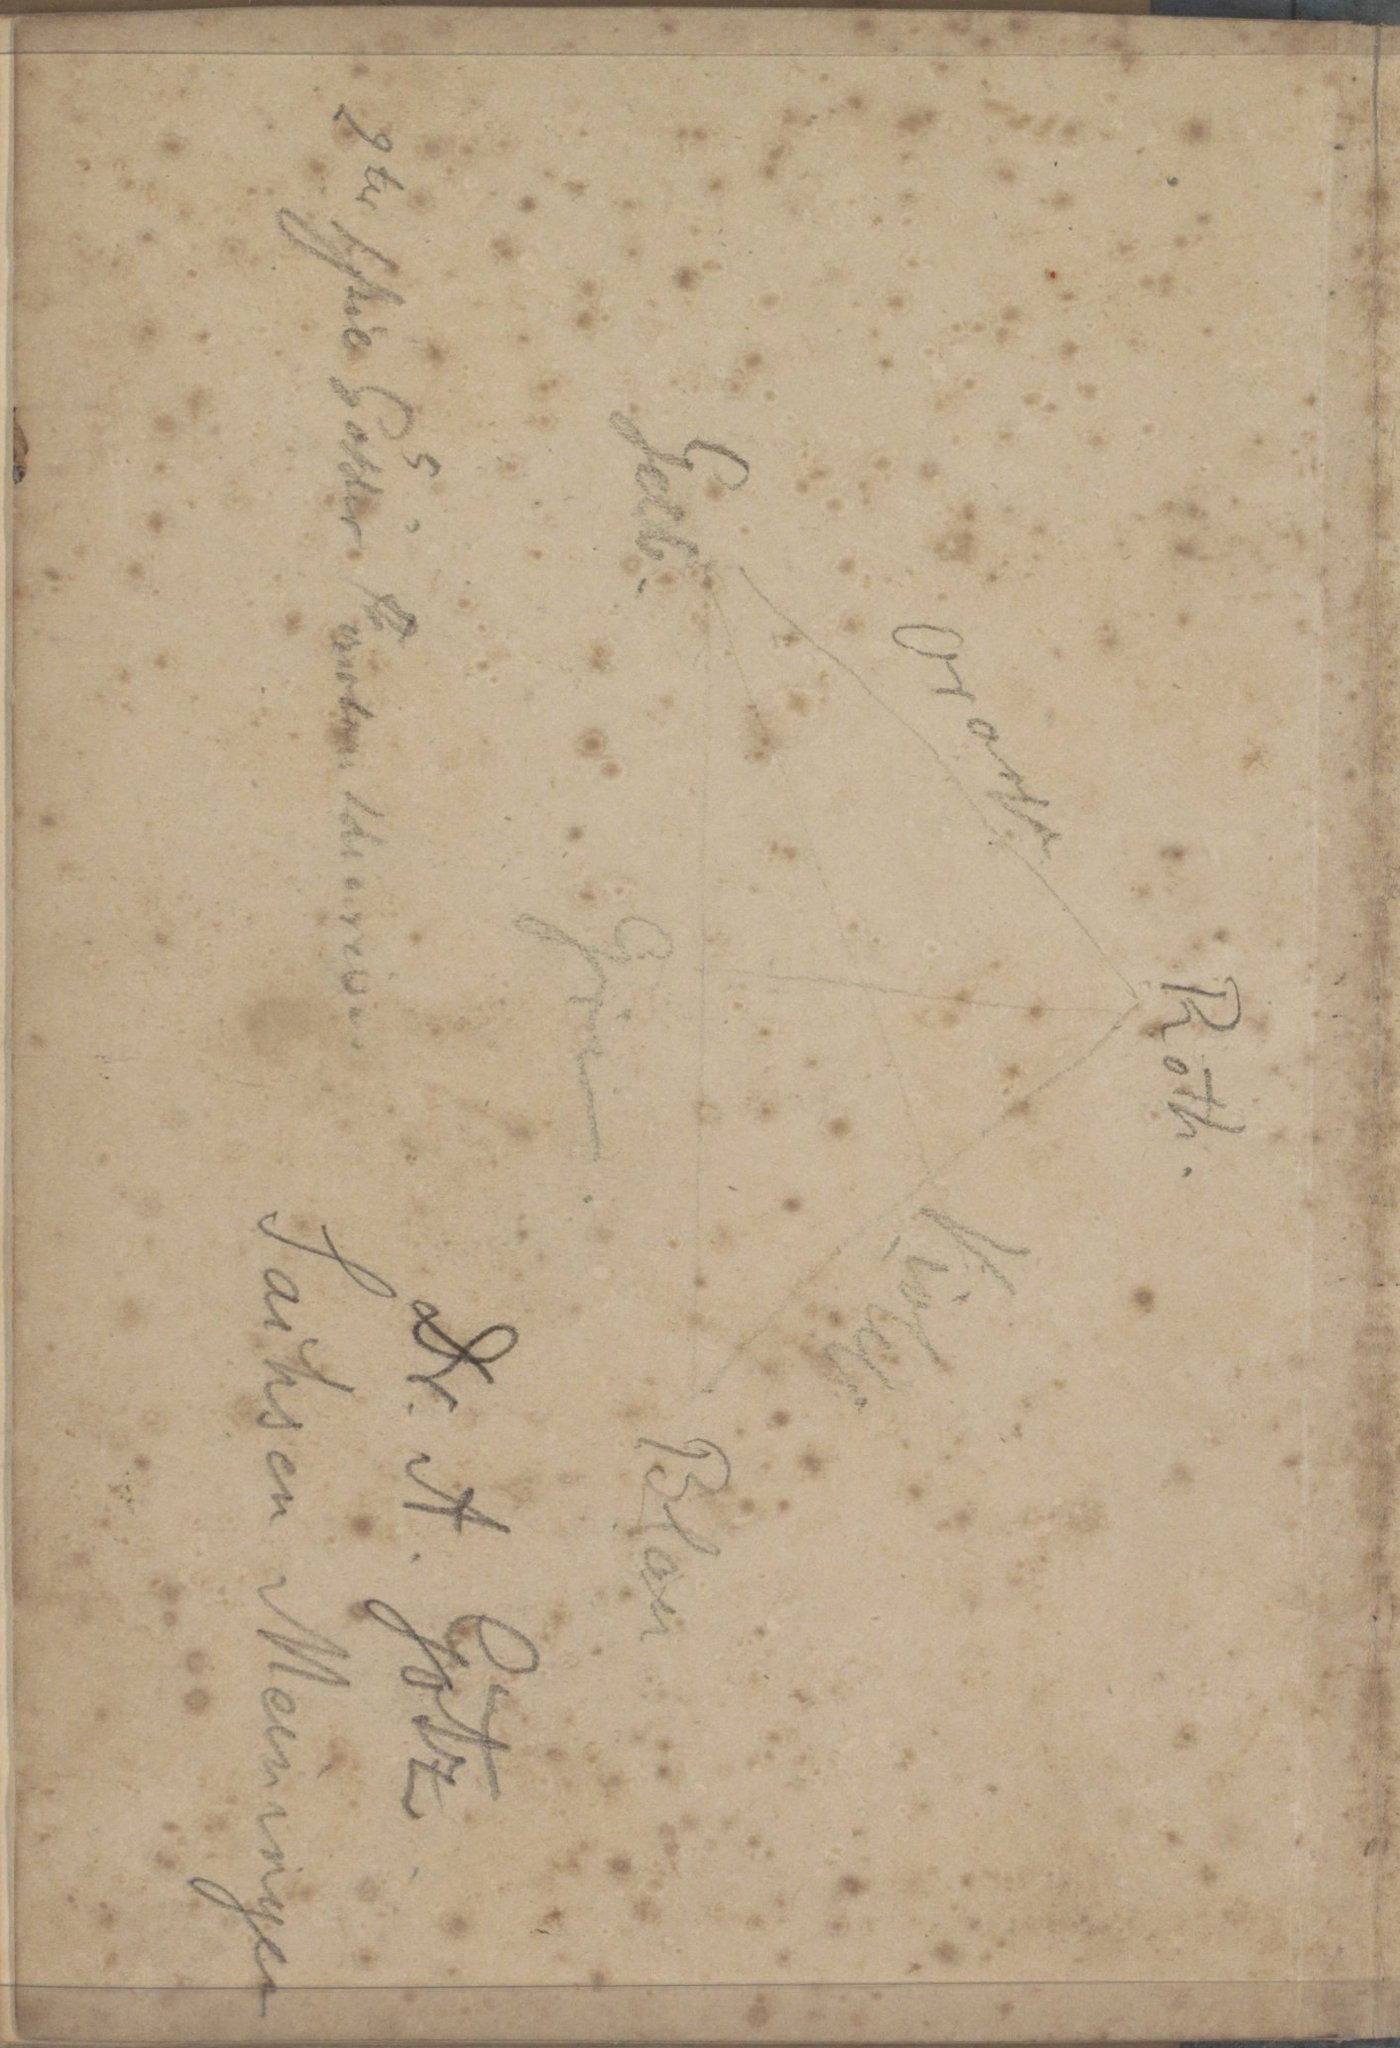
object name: sketchbook leaf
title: Kleurendriehoek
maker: johannes tavenraat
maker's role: draughtsman, painter, print maker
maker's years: 1809-1881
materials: paper, pencil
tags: triangle (~ planimetry, geometry)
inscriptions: annotation: ‘Roth/ Oranje/ Violet/ Gelb/ Gr[...]/ Blou/ 2ter [...]ier Gotter [...]/ Dr. A. Gotz/ Saksen Meiningen’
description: Blad 47 verso uit een schetsboek met 47 bladen.